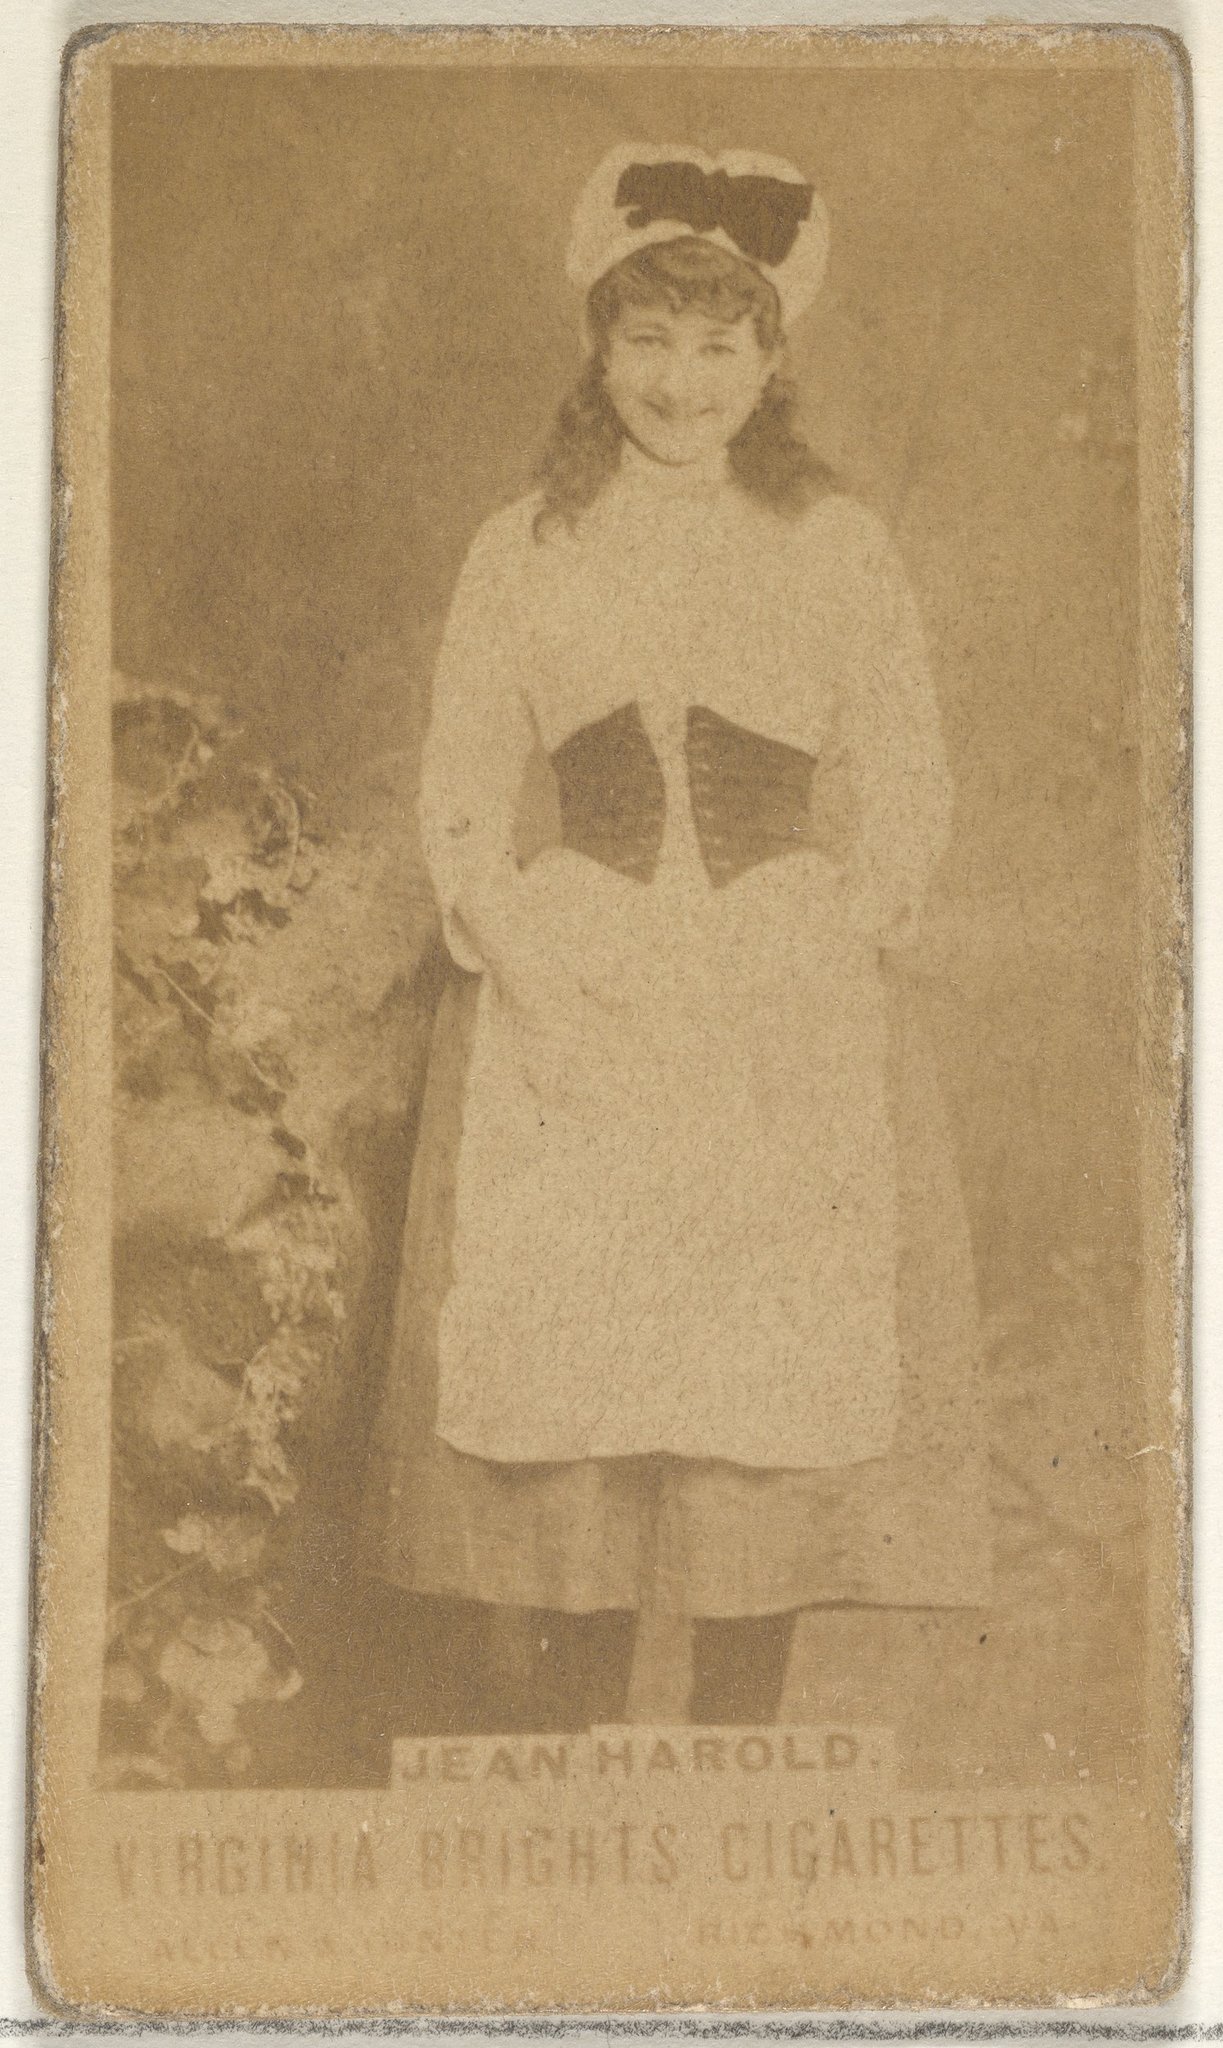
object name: photograph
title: Jean Harold, from the Actors and Actresses series (N45, Type 1) for Virginia Brights Cigarettes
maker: allen & ginter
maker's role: publisher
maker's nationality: american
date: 1888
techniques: albumen silver print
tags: portraits,women,actresses